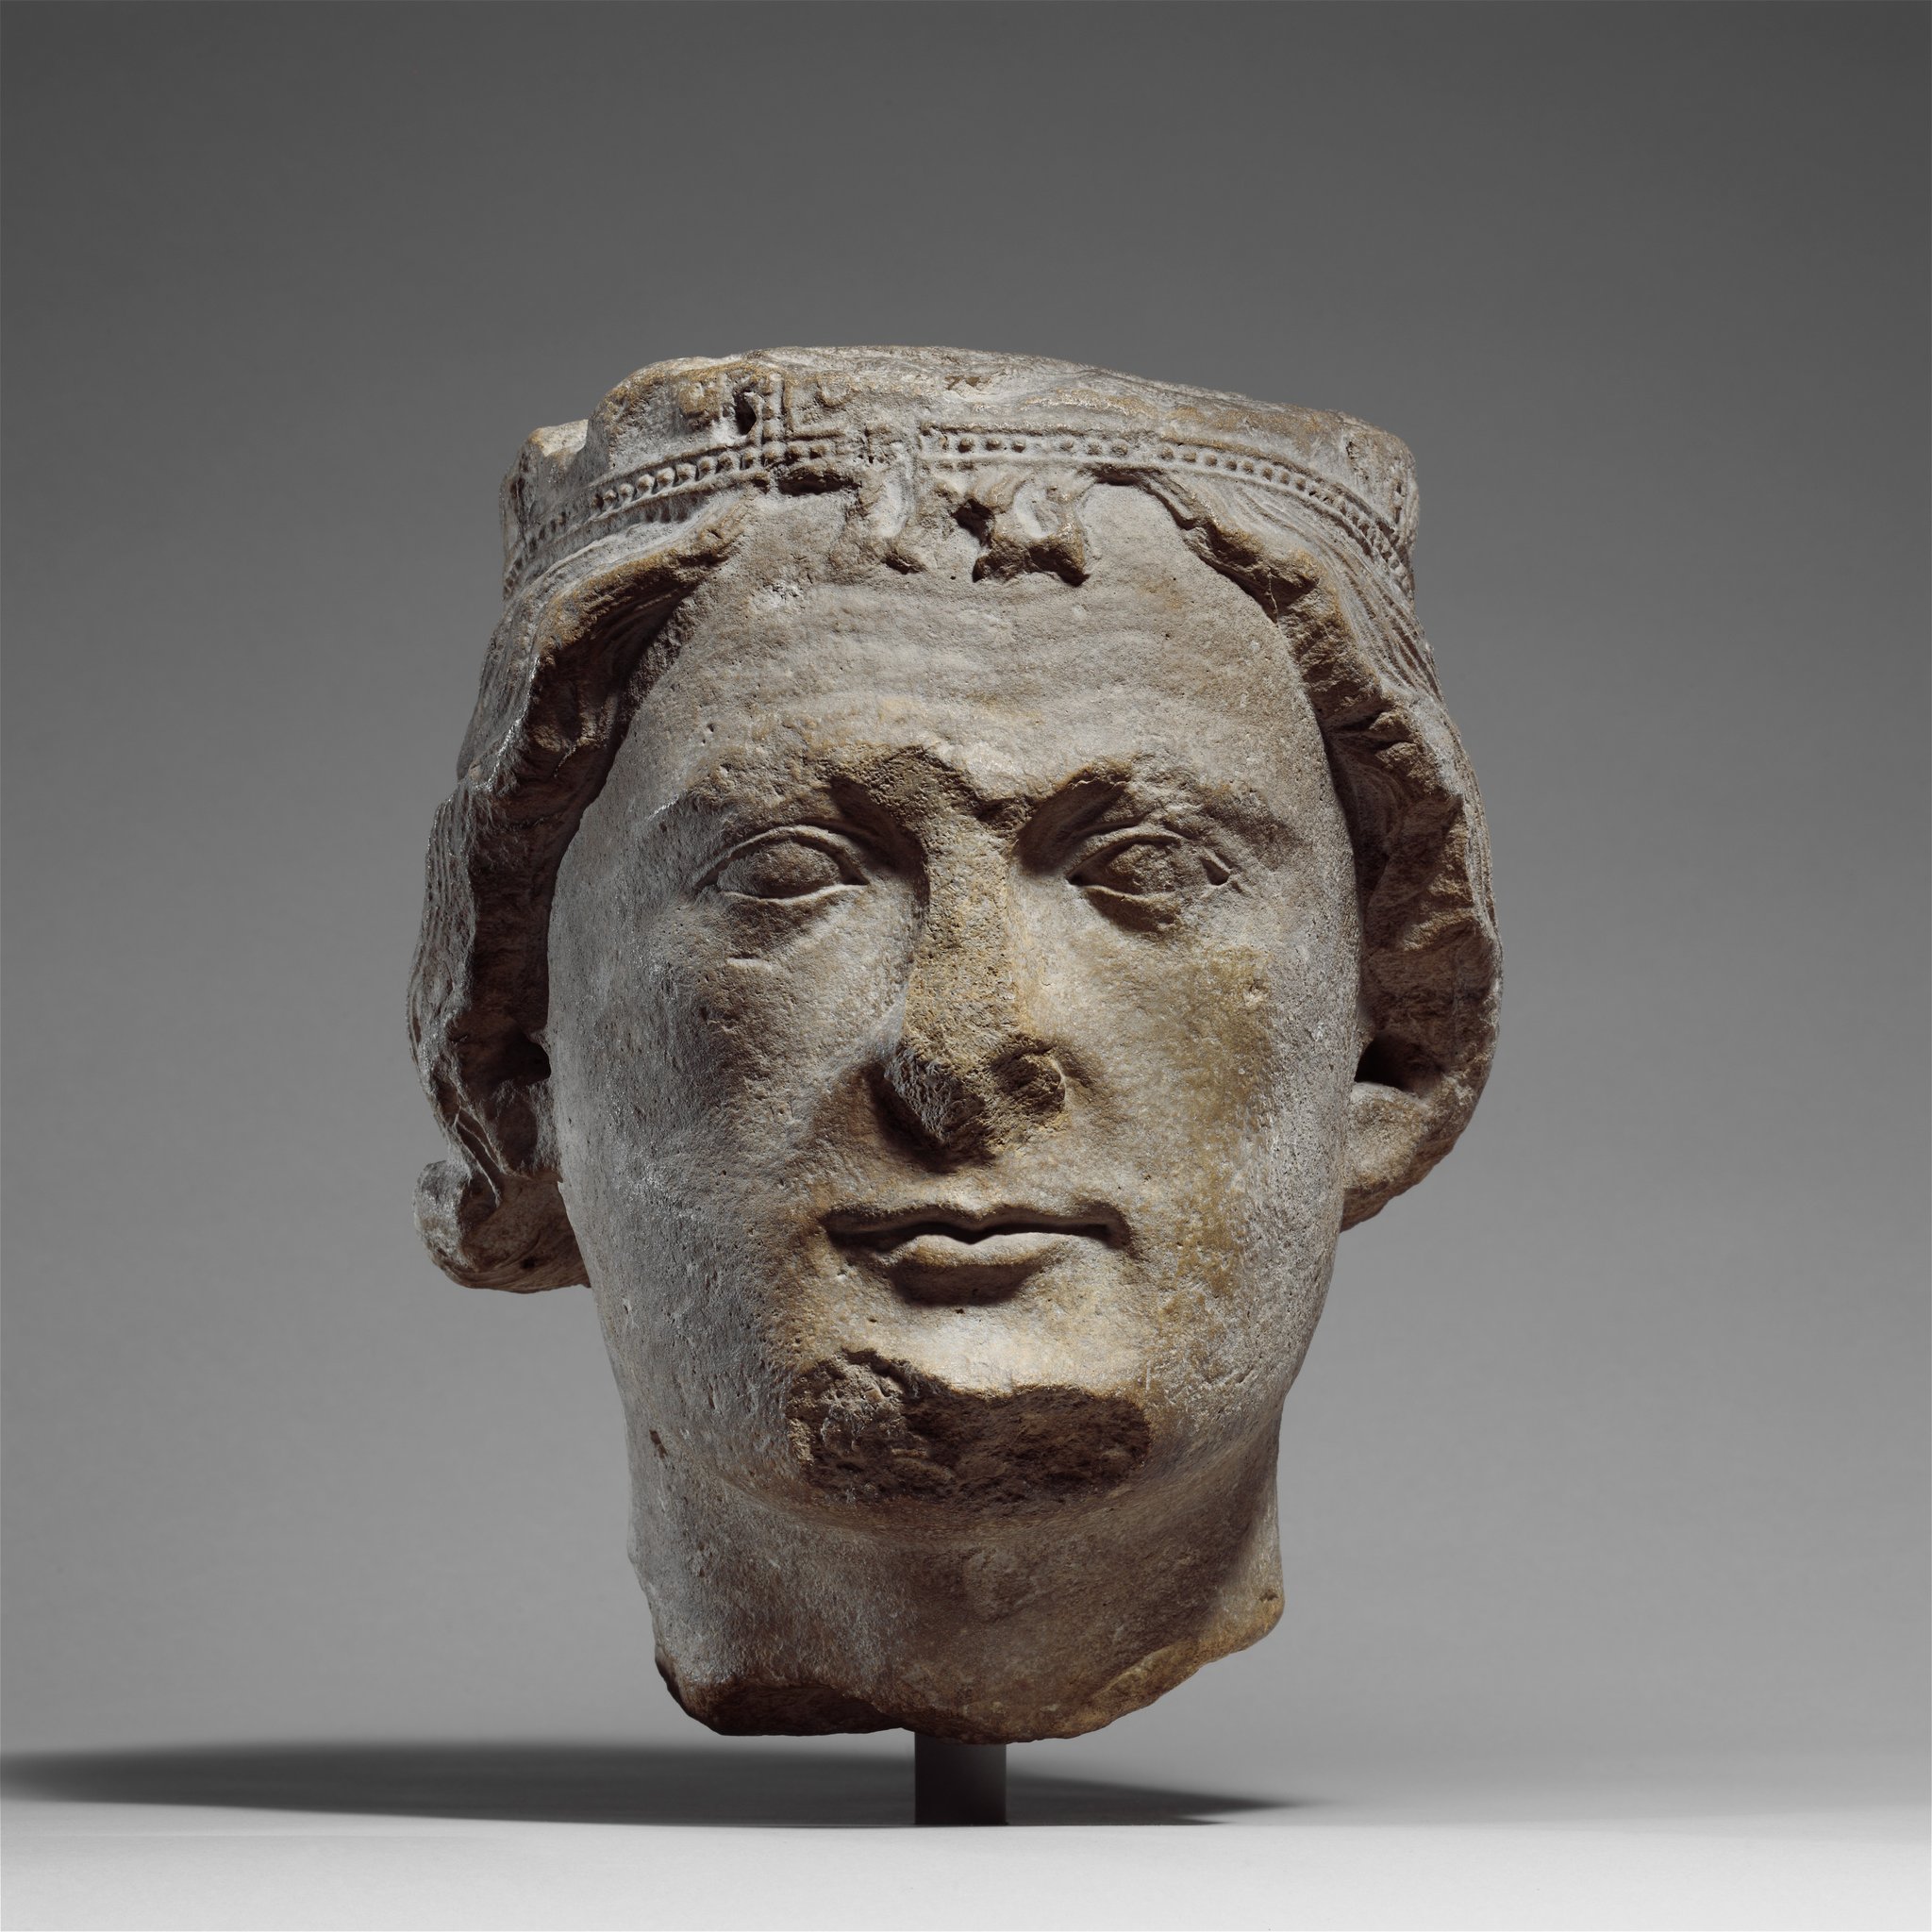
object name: statue head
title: Head of a King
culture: french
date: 1220-1230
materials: limestone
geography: france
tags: kings